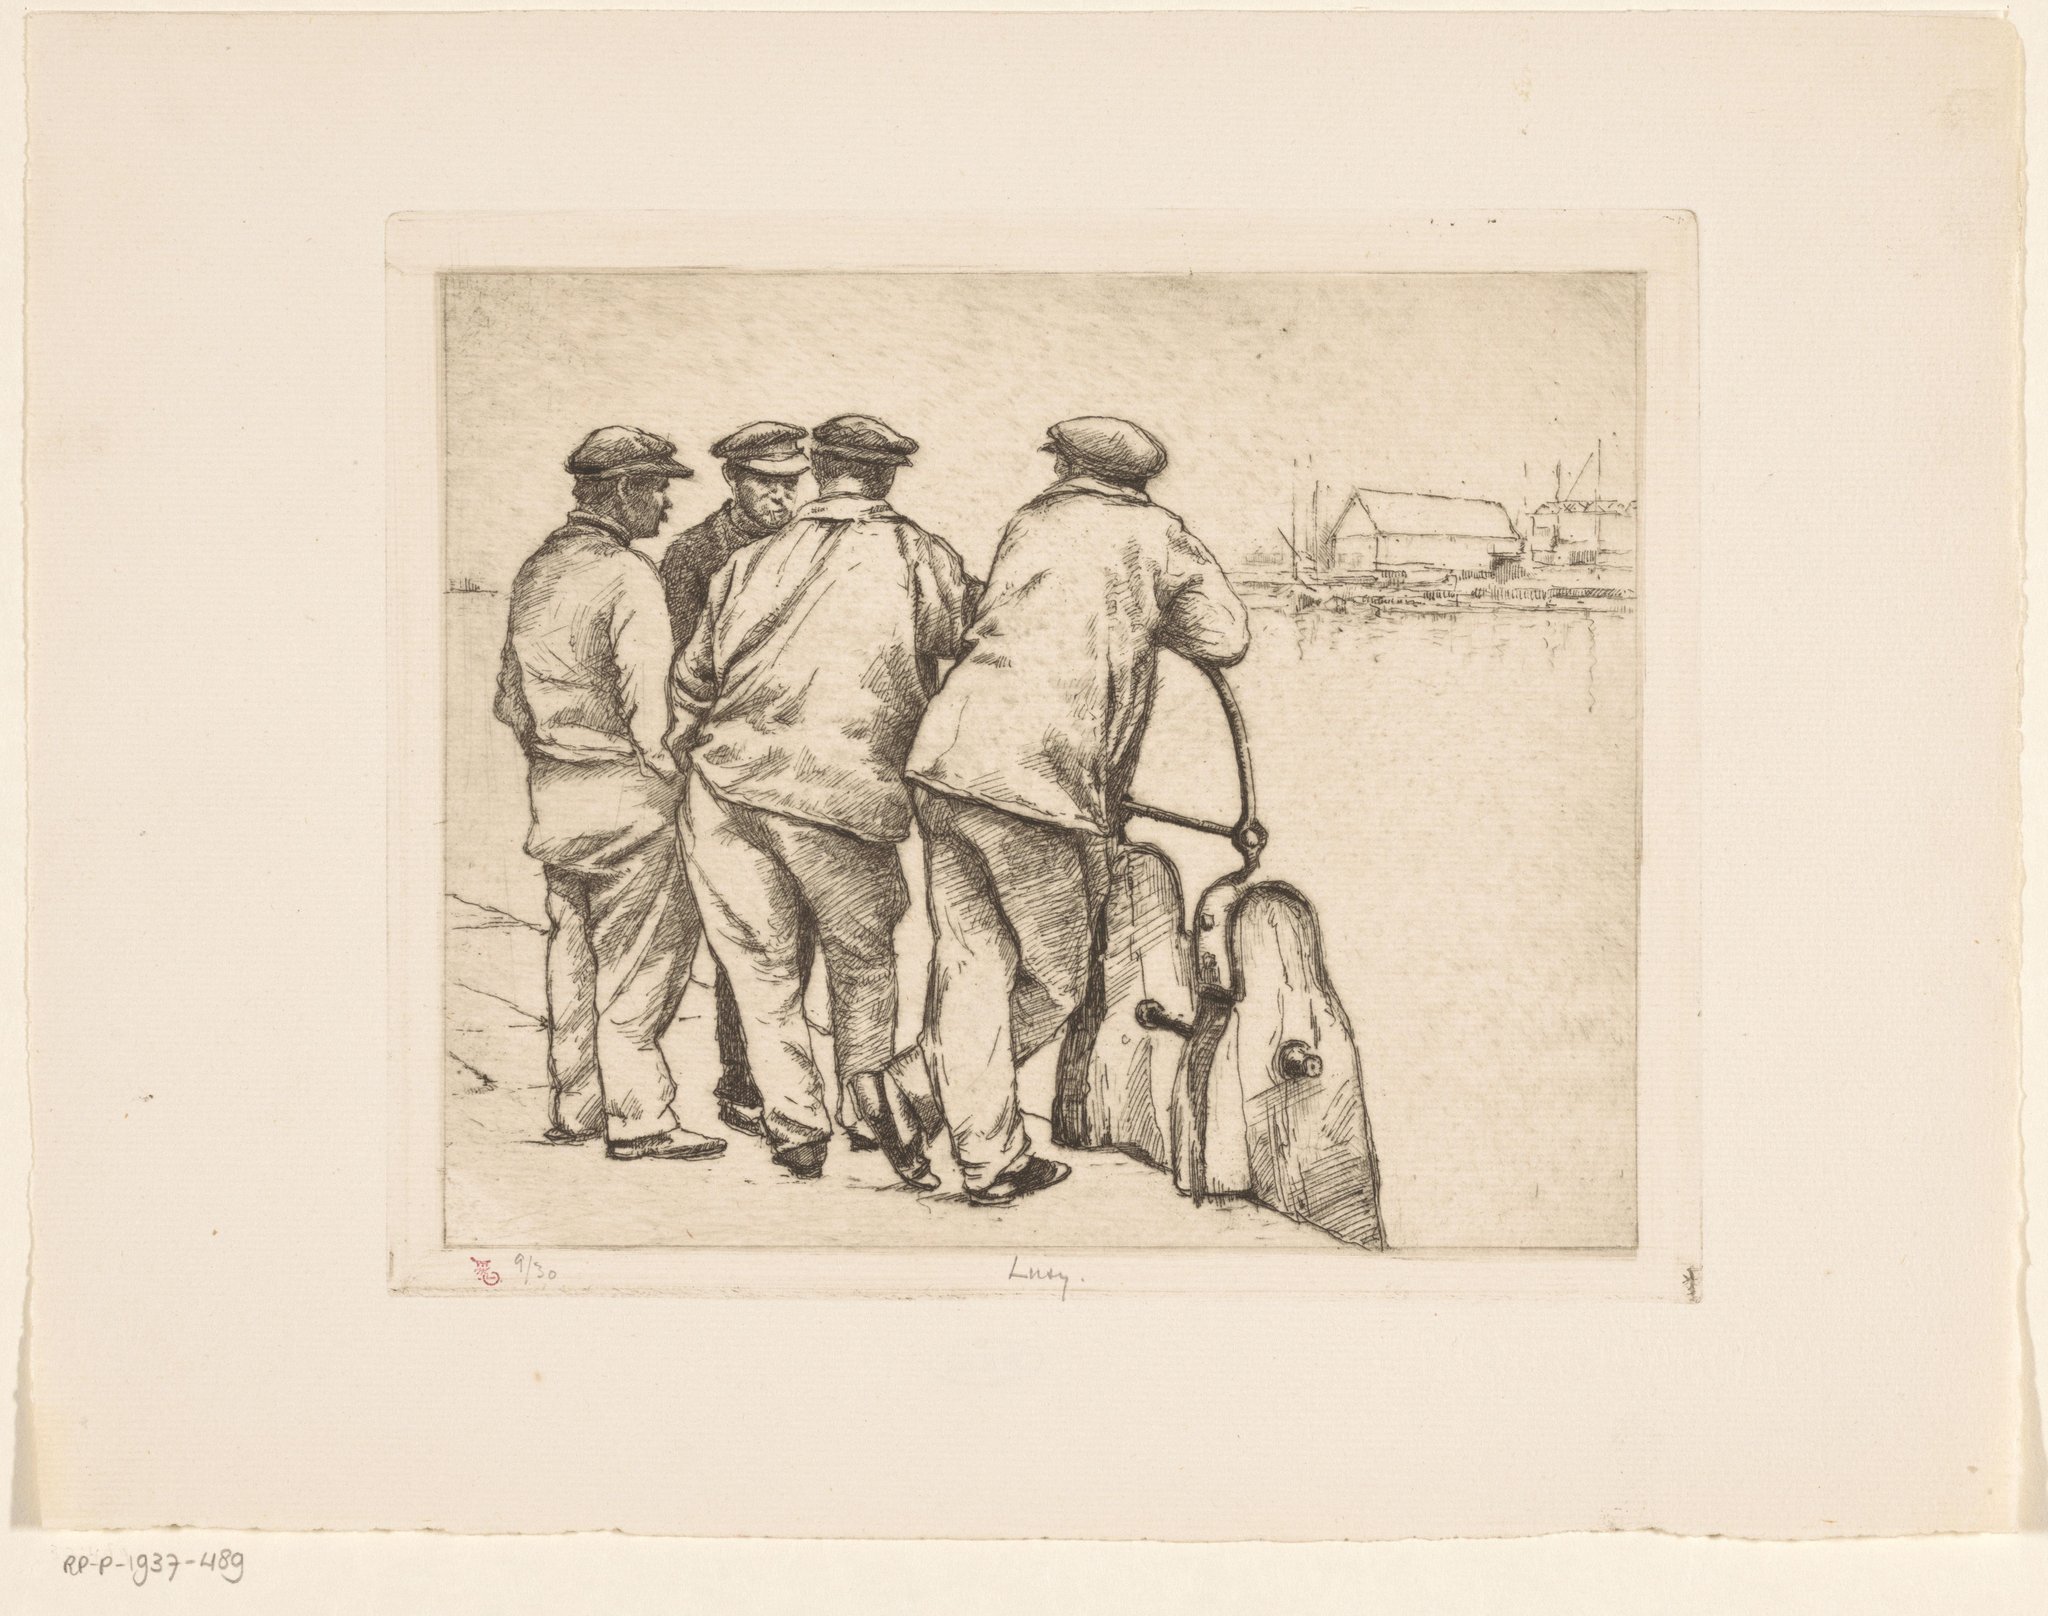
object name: print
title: Pratende havenwerkers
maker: marino m. lusy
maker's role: print maker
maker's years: 1880-1954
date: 1890-1937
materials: paper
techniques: drypoint, etching, intaglio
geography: italy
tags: dock labourer, conversation, dialogue; conversation piece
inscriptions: collector's mark: Lugt 2228, collector's mark: Lugt 2412a, number: ‘9/30’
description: Vier havenwerkers in gesprek aan de waterkant.